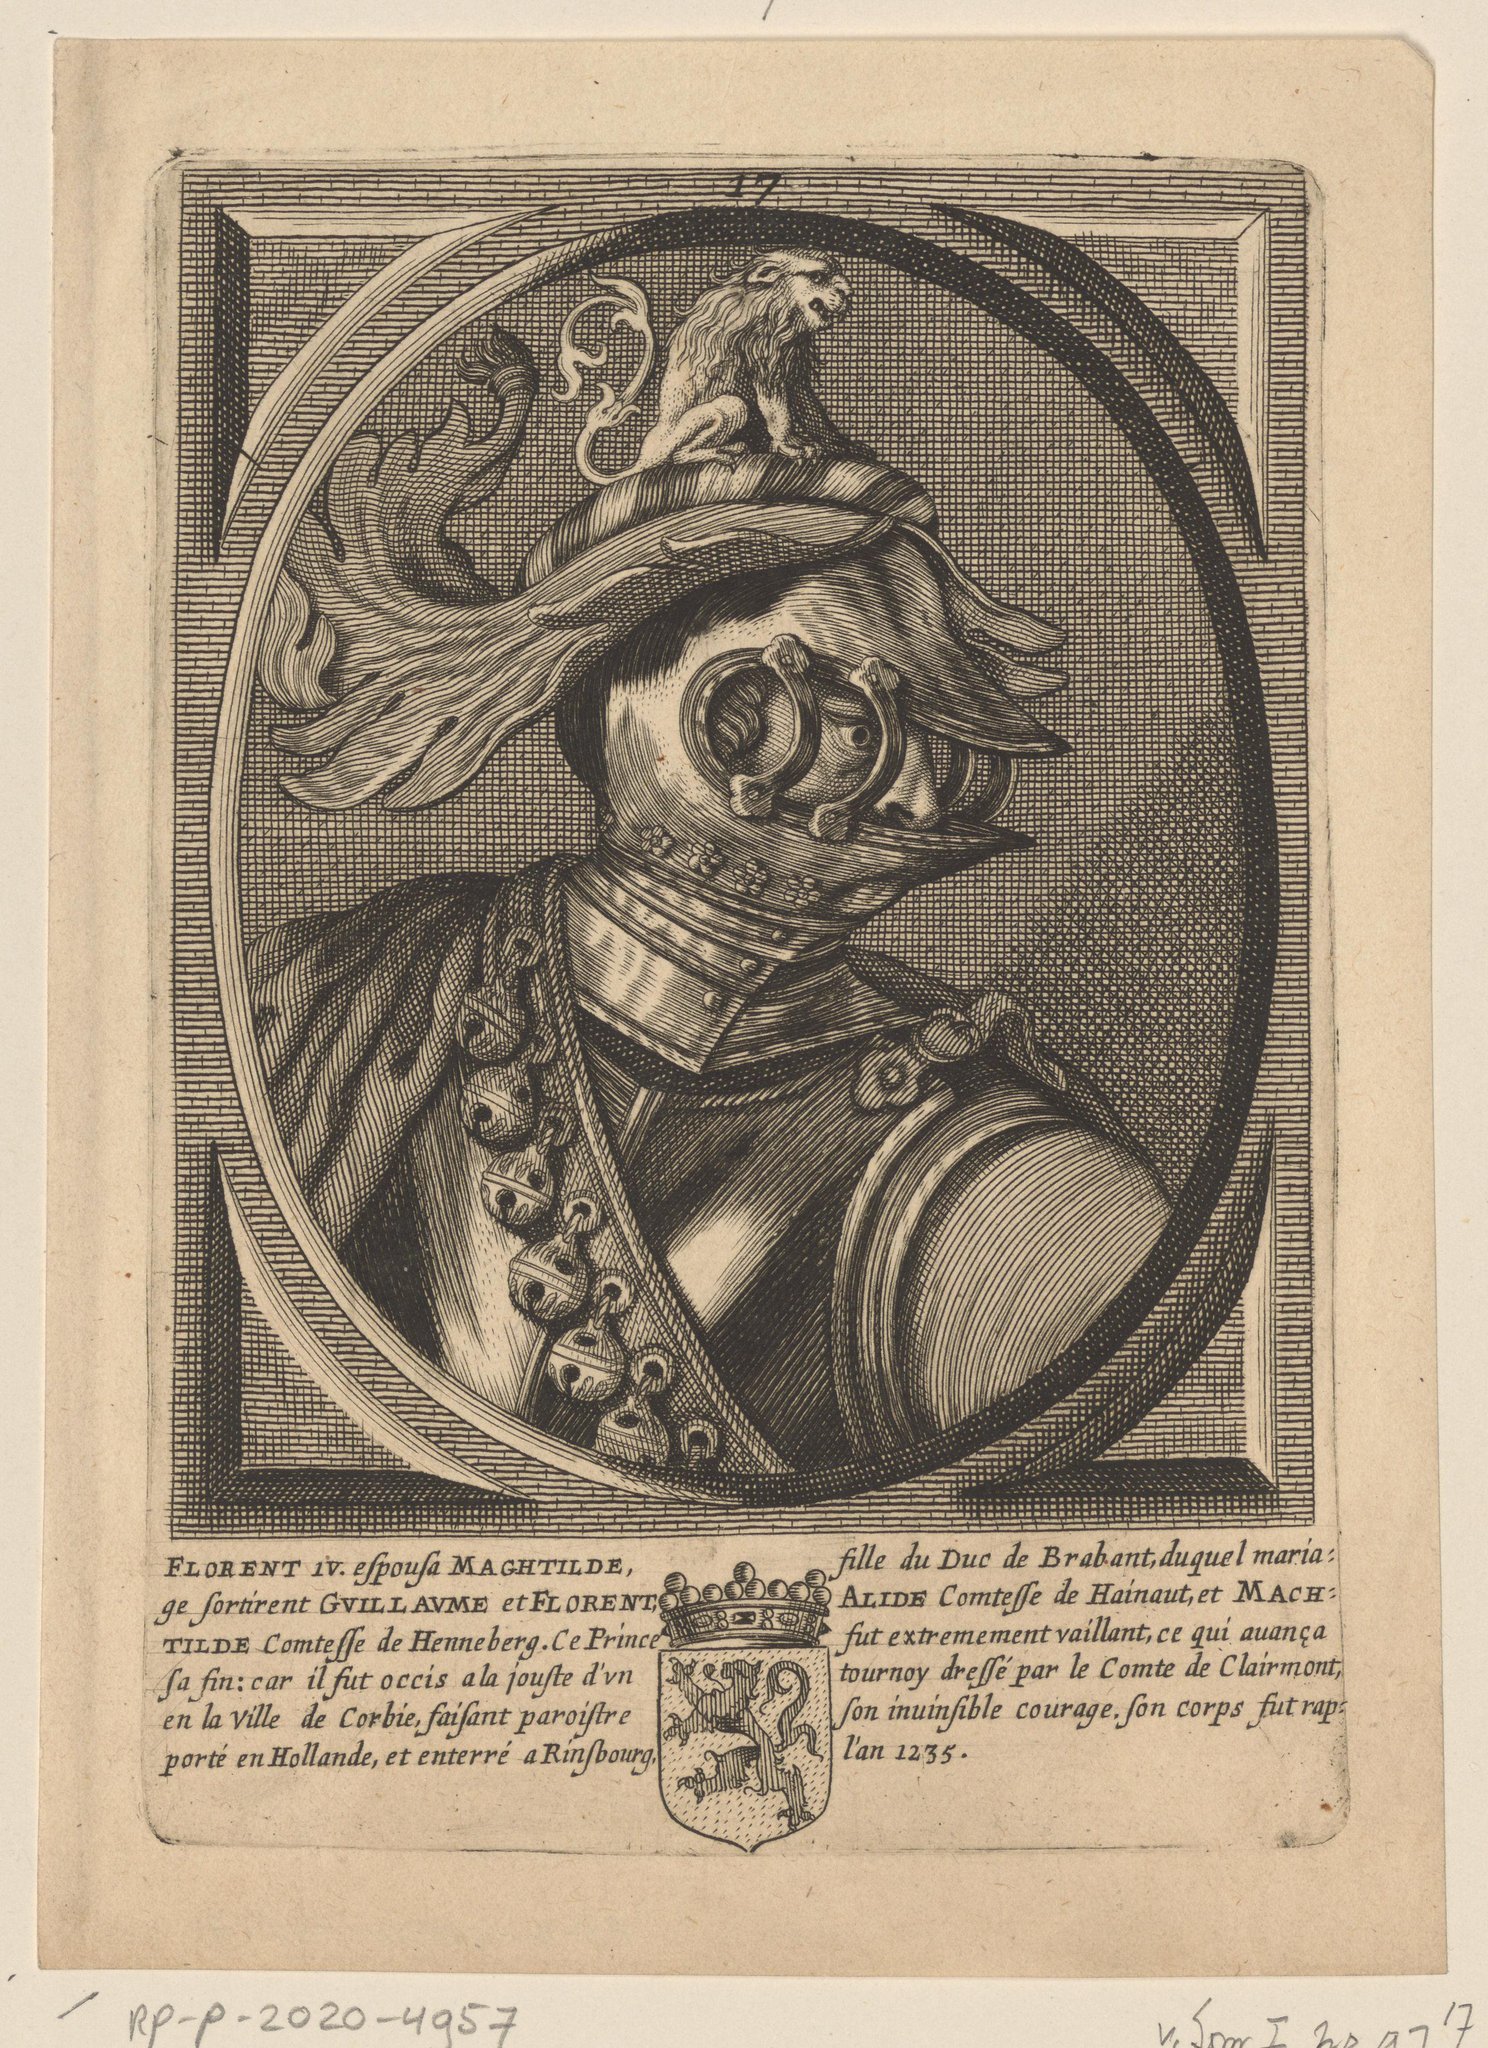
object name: book illustration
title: Portret van Floris IV, graaf van Holland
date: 1662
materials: paper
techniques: engraving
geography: antwerp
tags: floris iv (graaf van holland), coat of arms (as symbol of the state, etc.), armour, historical persons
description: Midden boven genummerd: 17. Met onderschrift in het Frans.